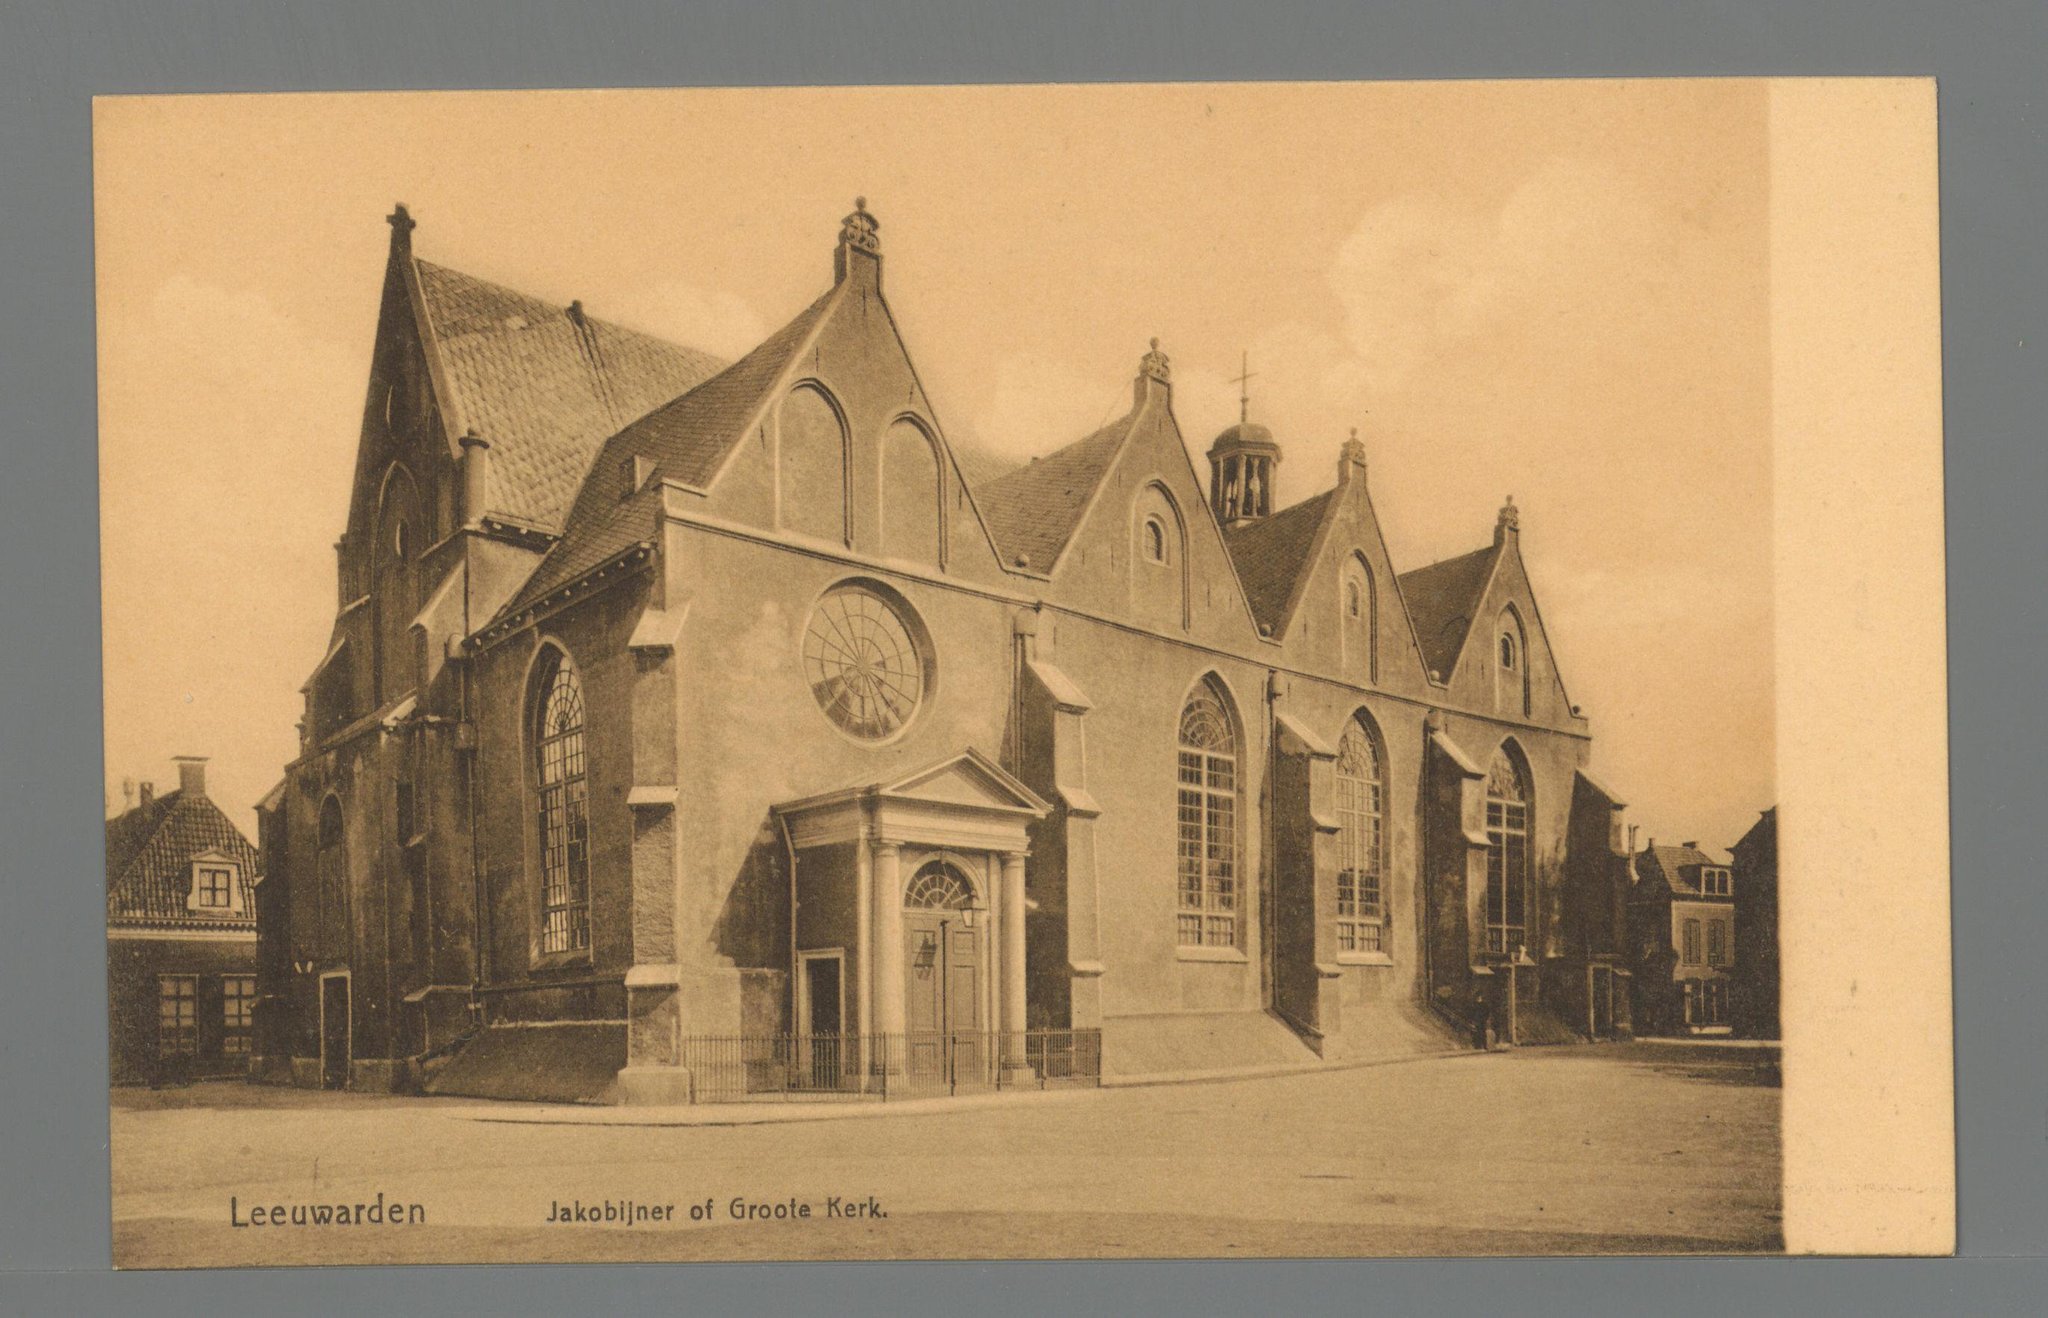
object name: photomechanical print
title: Leeuwarden. Jakobijner of Groote Kerk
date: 1905-1930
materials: cardboard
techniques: photograph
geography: leeuwarden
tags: church (exterior)